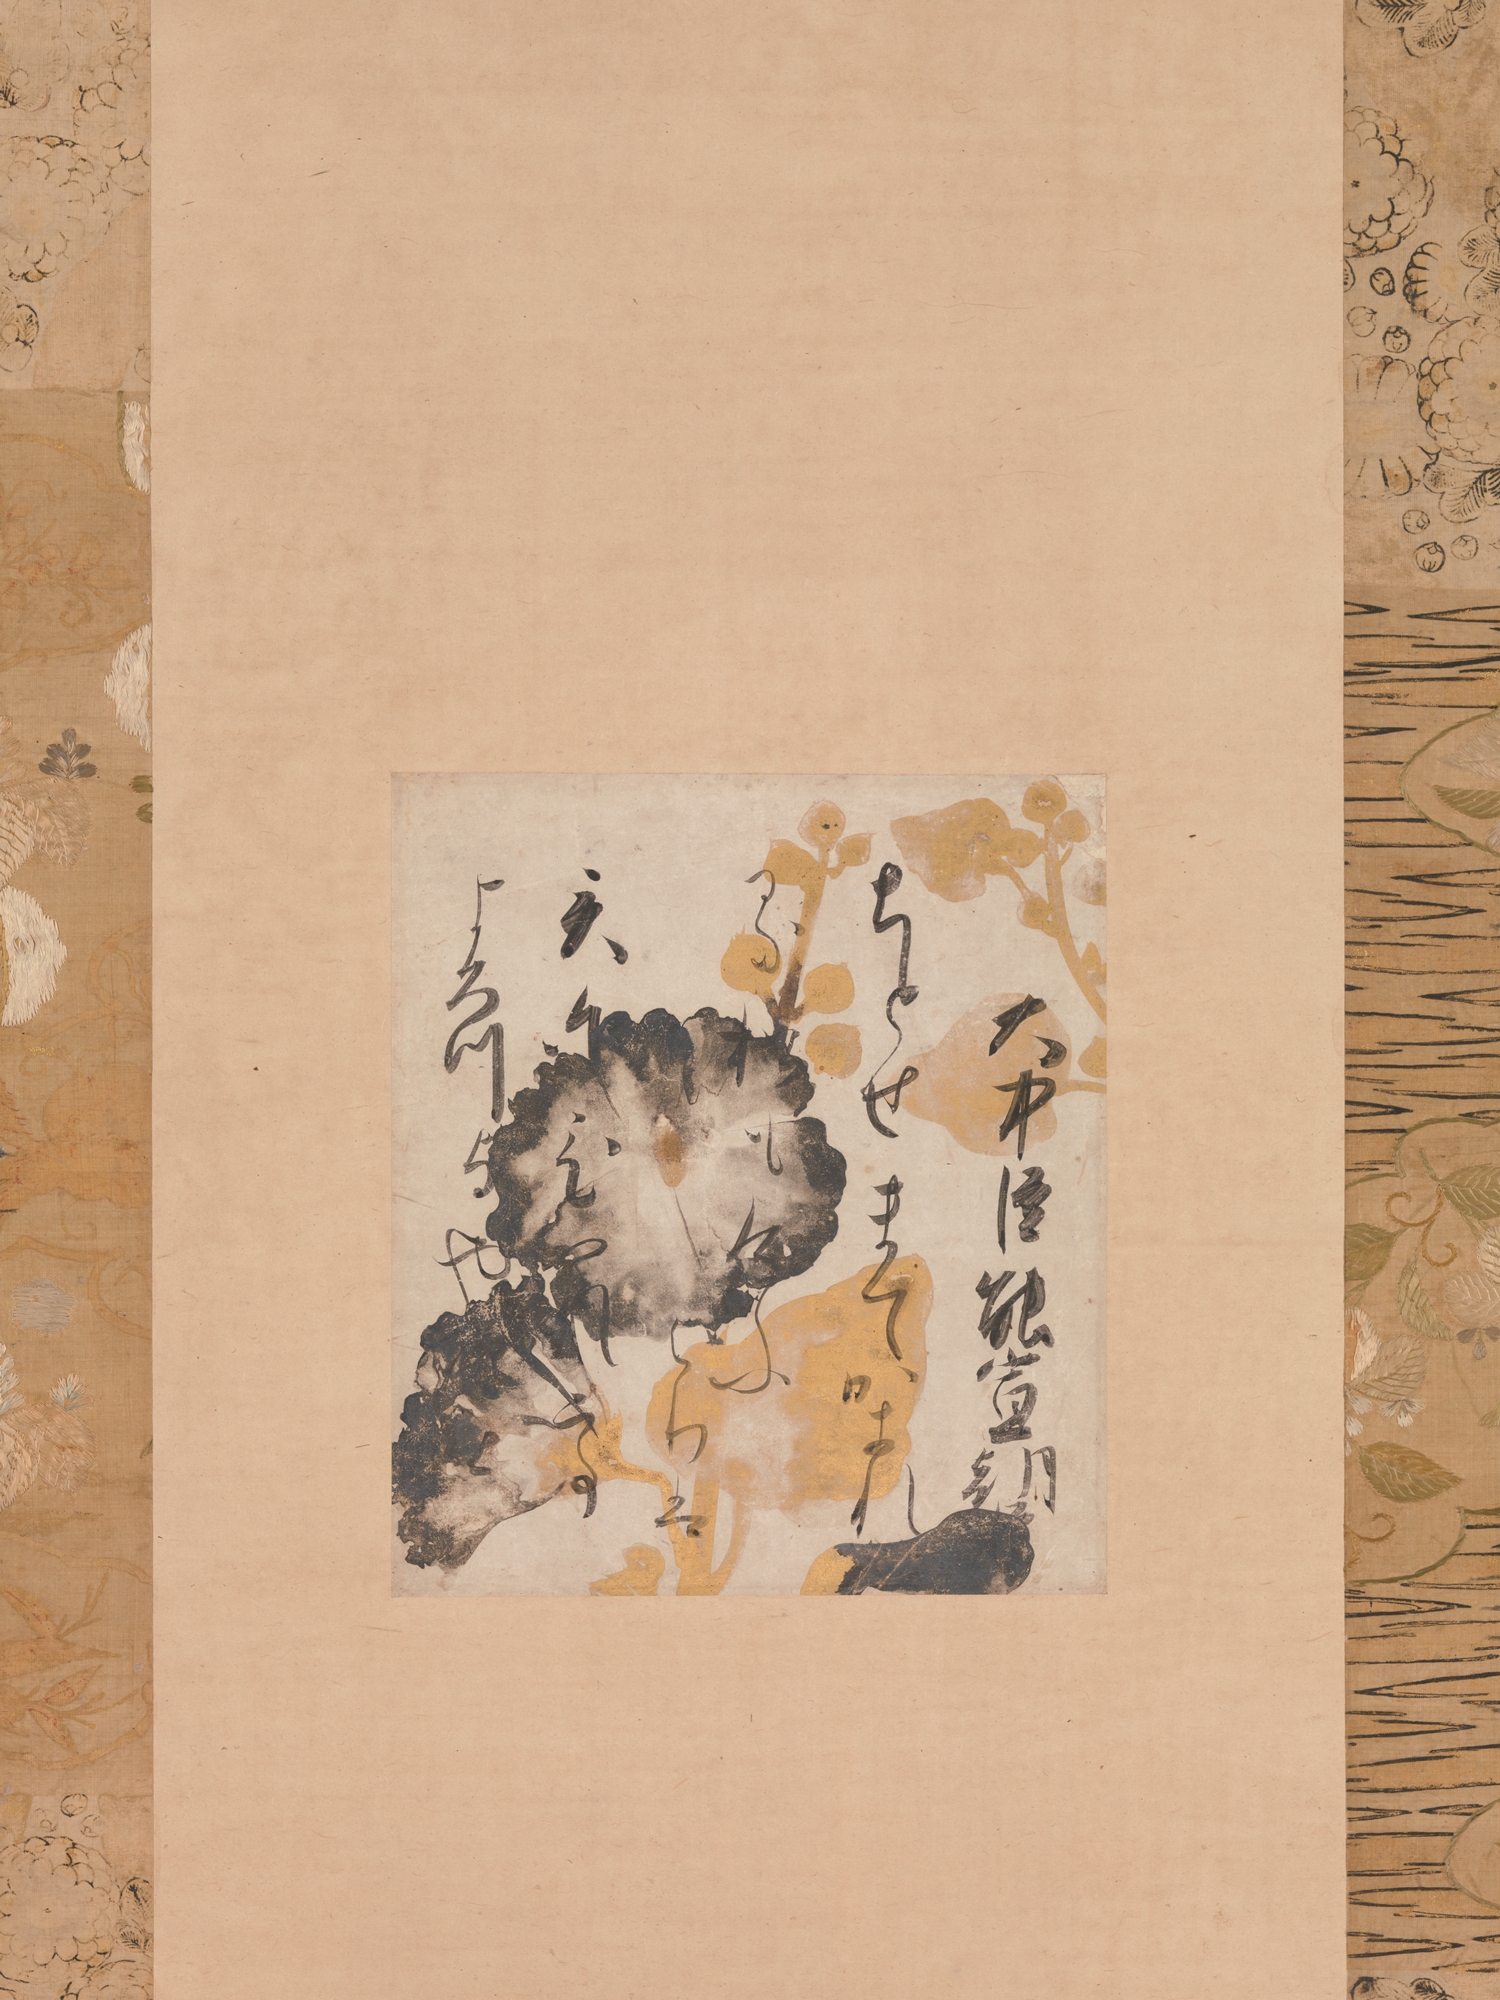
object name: hanging scroll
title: Poem by Onakatomi Yoshinobu with Underpainting of Hollyhocks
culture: japanese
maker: shōkadō shōjō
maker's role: artist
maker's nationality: japanese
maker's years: 1584-1639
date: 1601-1633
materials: gold, ink, paper, silver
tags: poetry,flowers